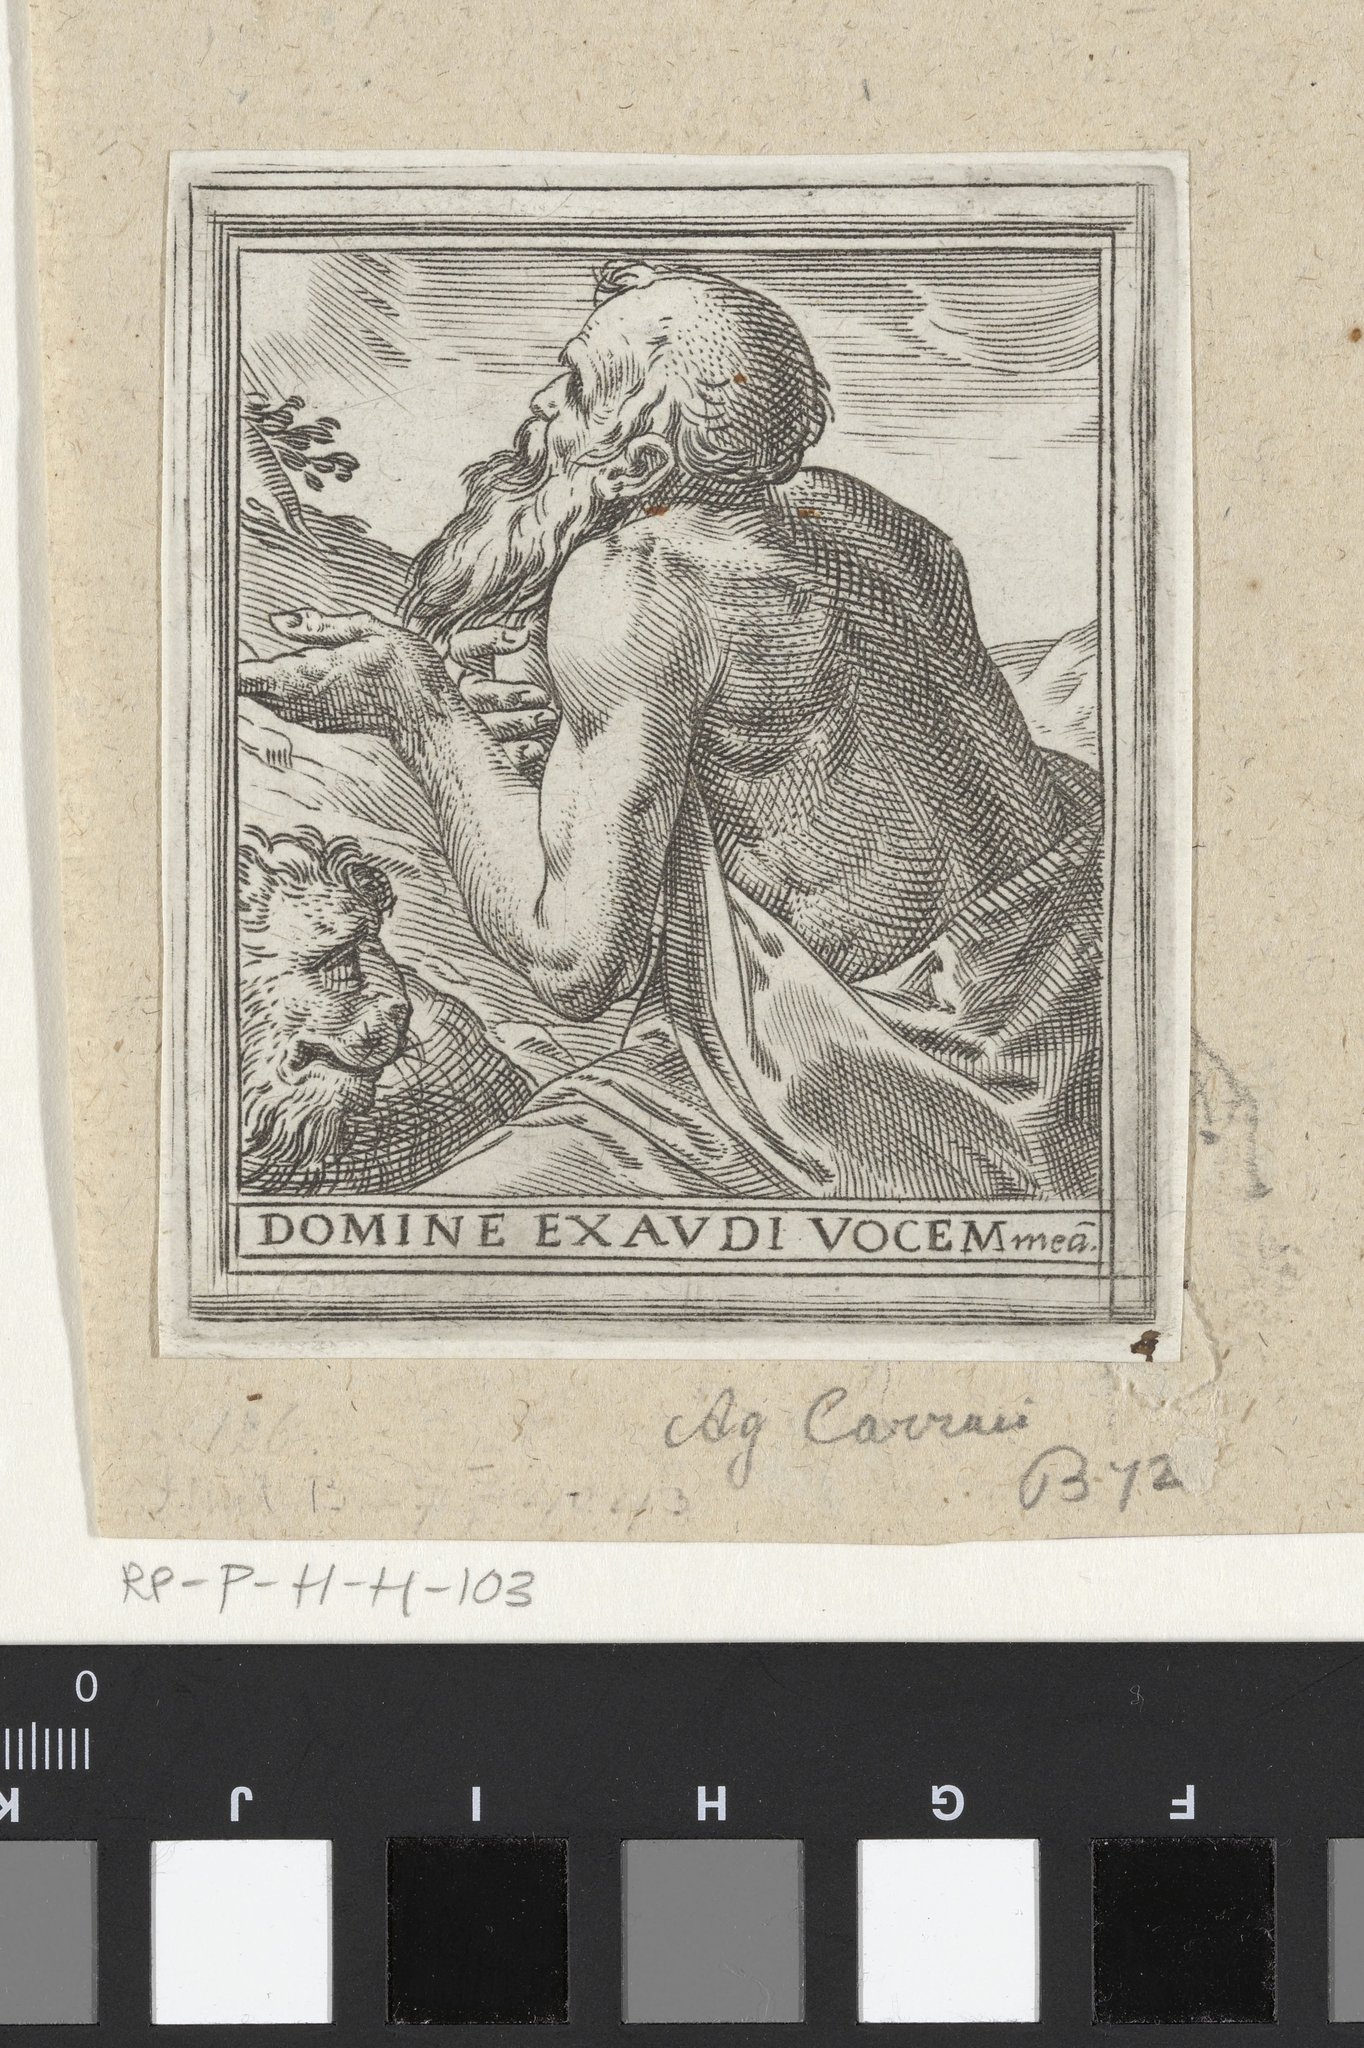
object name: print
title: Heilige Hieronymus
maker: agostino carracci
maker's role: draughtsman, painter, print maker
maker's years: 1557-1602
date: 1581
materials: paper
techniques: engraving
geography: rome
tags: the monk and hermit jerome (hieronymus); possible attributes: book, cardinal's hat, crucifix, hour-glass, lion, skull, stone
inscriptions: collector's mark: Lugt 11, collector's mark: ‘Hinloopen’, number: ‘4’, collector's mark: Lugt 10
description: De heilige Hieronymus, op de rug gezien, in een landschap met een leeuw.